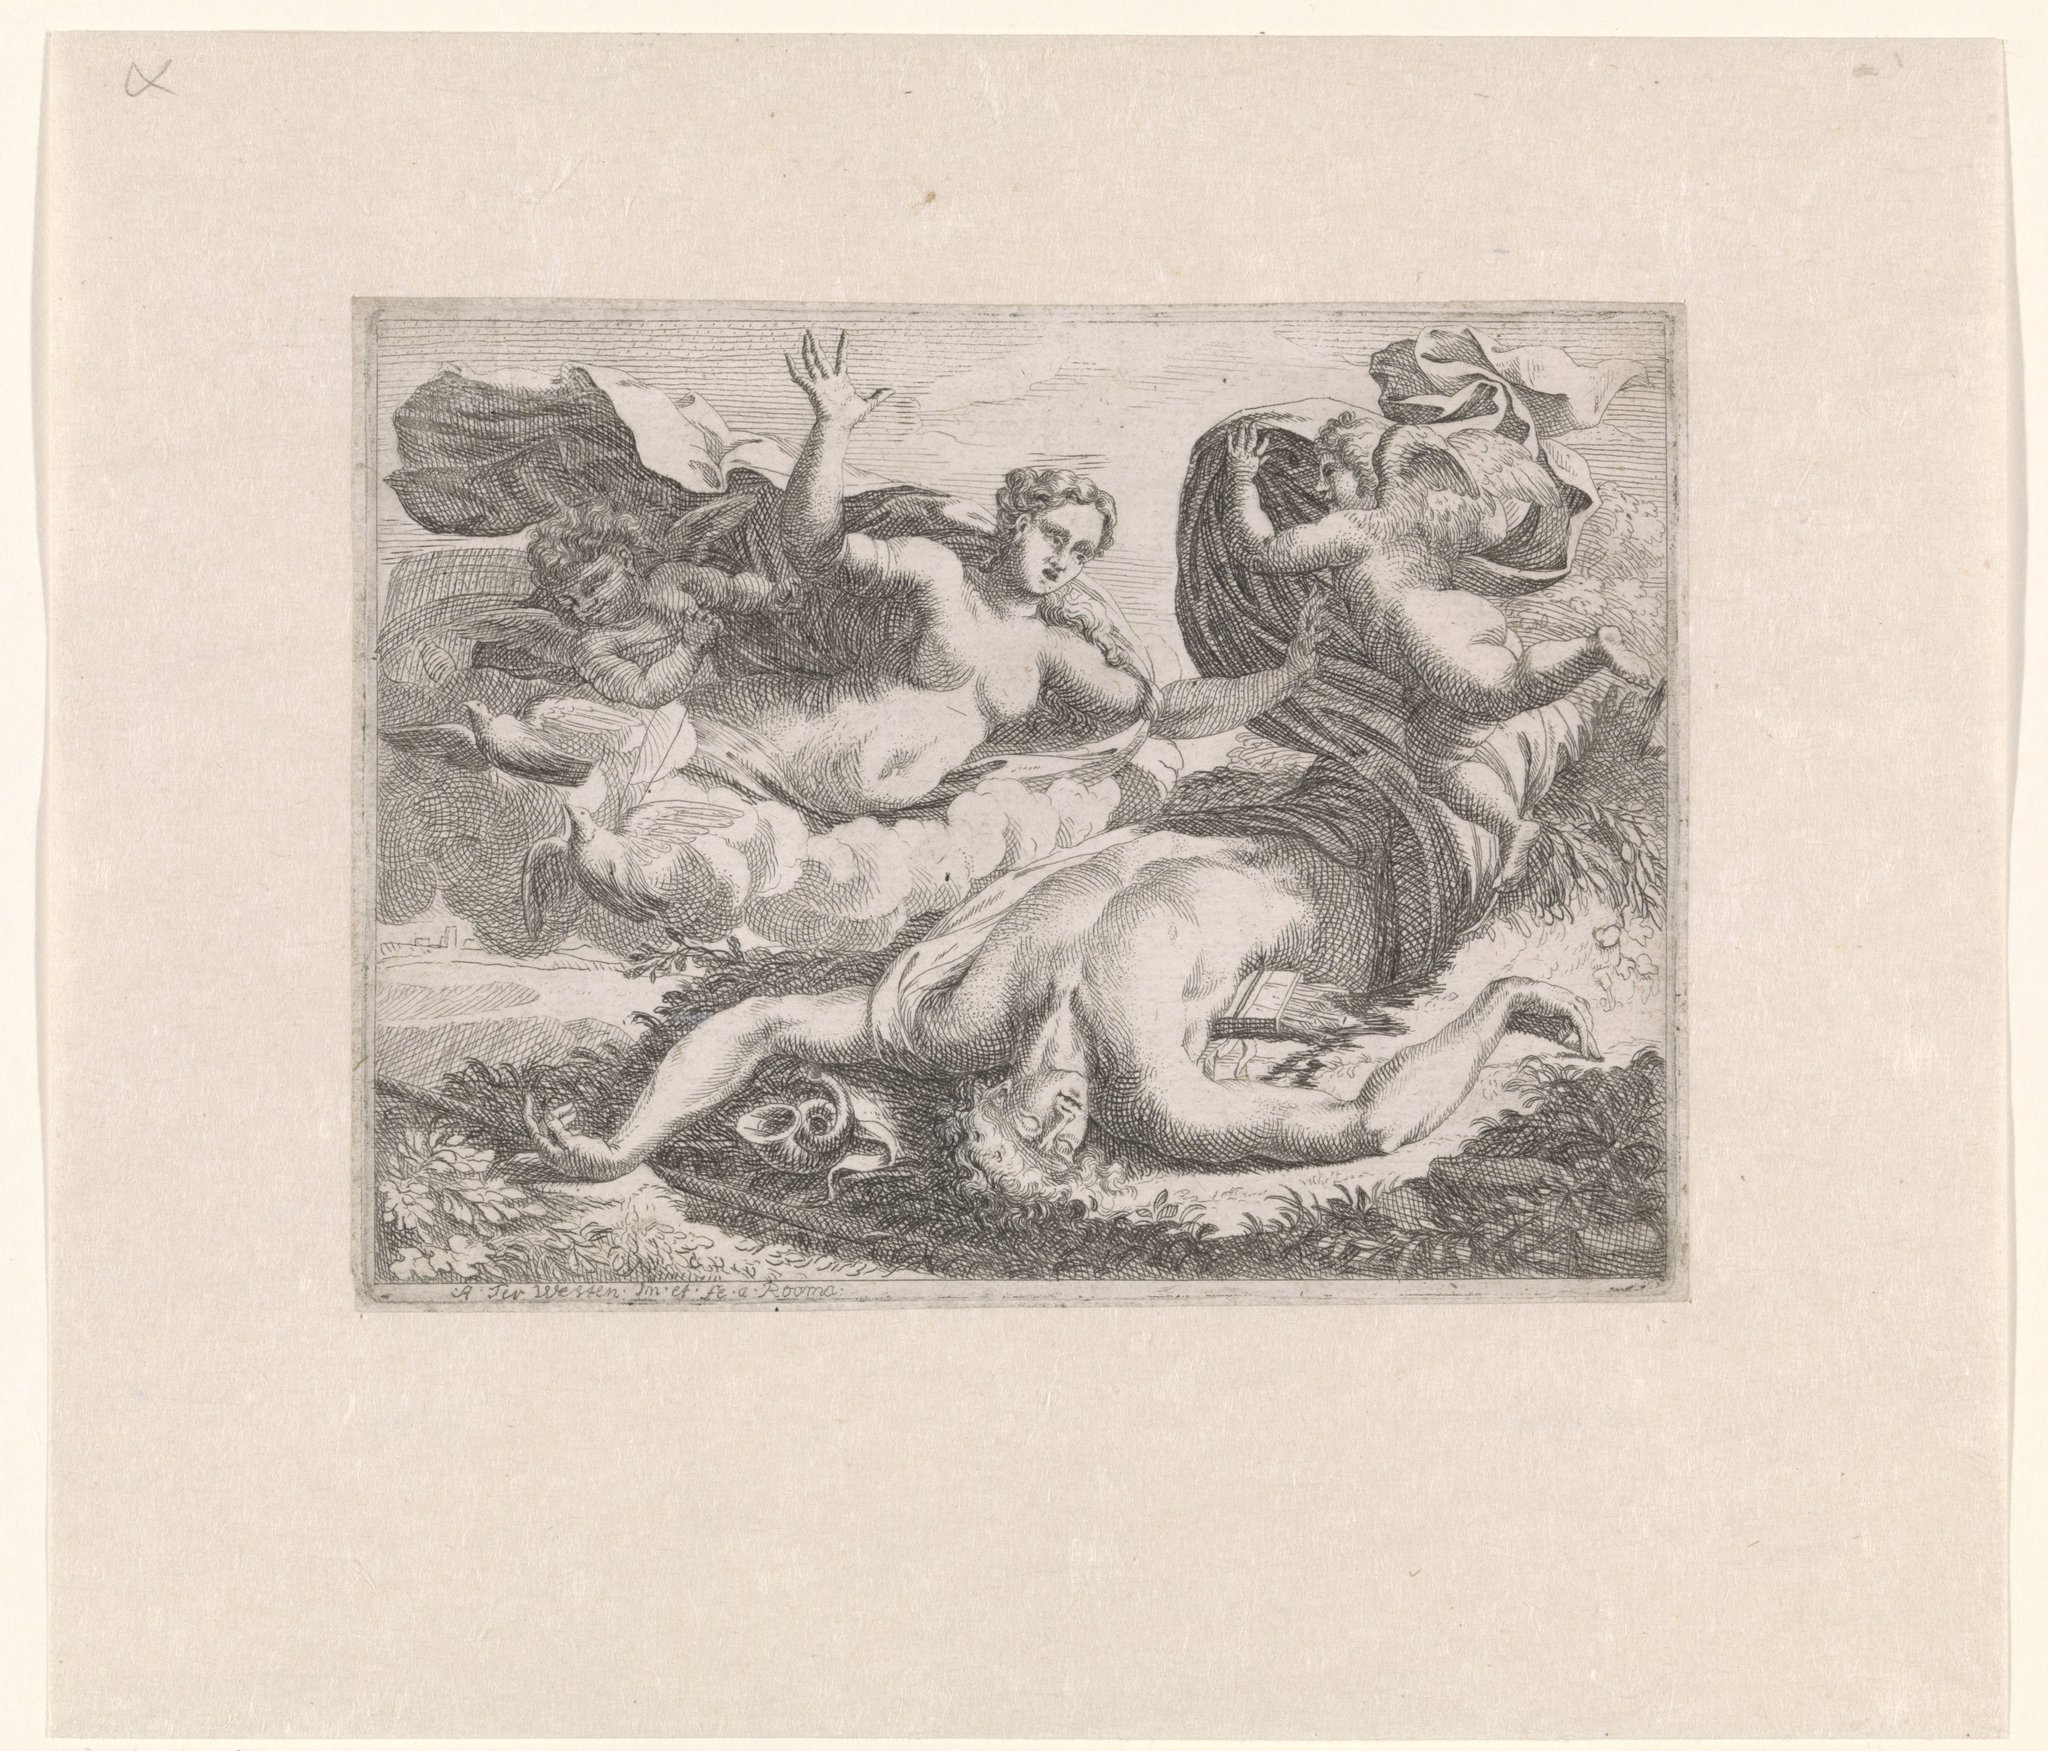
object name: print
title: Venus treurt bij de dode Adonis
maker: augustinus terwesten (i)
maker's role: draughtsman, painter, print maker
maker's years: 1649-1711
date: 1672-1677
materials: paper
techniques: etching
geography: rome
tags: venus mourning adonis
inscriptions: collector's mark: Lugt 2760, collector's mark: Lugt 2228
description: Venus, op een wolk, treurt om haar geliefde Adonis, die tijdens de jacht is gedood door een wild zwijn. Amor bestuurt de door duiven getrokken wolk.